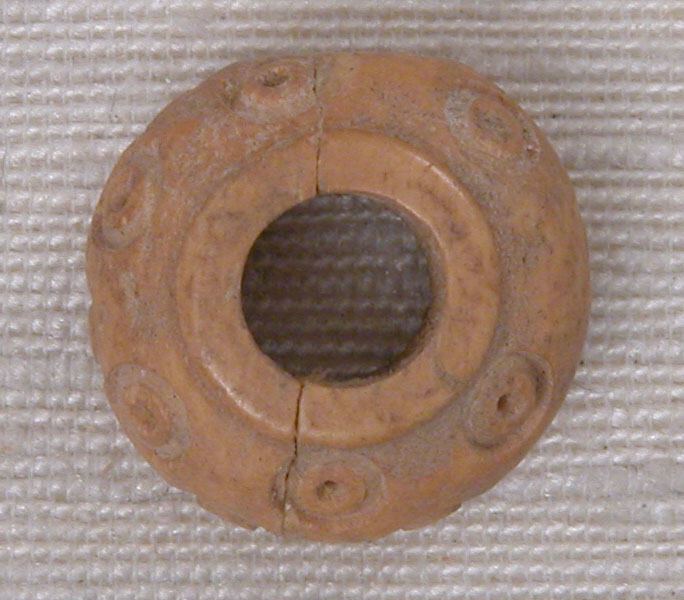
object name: button or bead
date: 801-1000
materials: bone, paint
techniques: incising, inlay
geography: iran